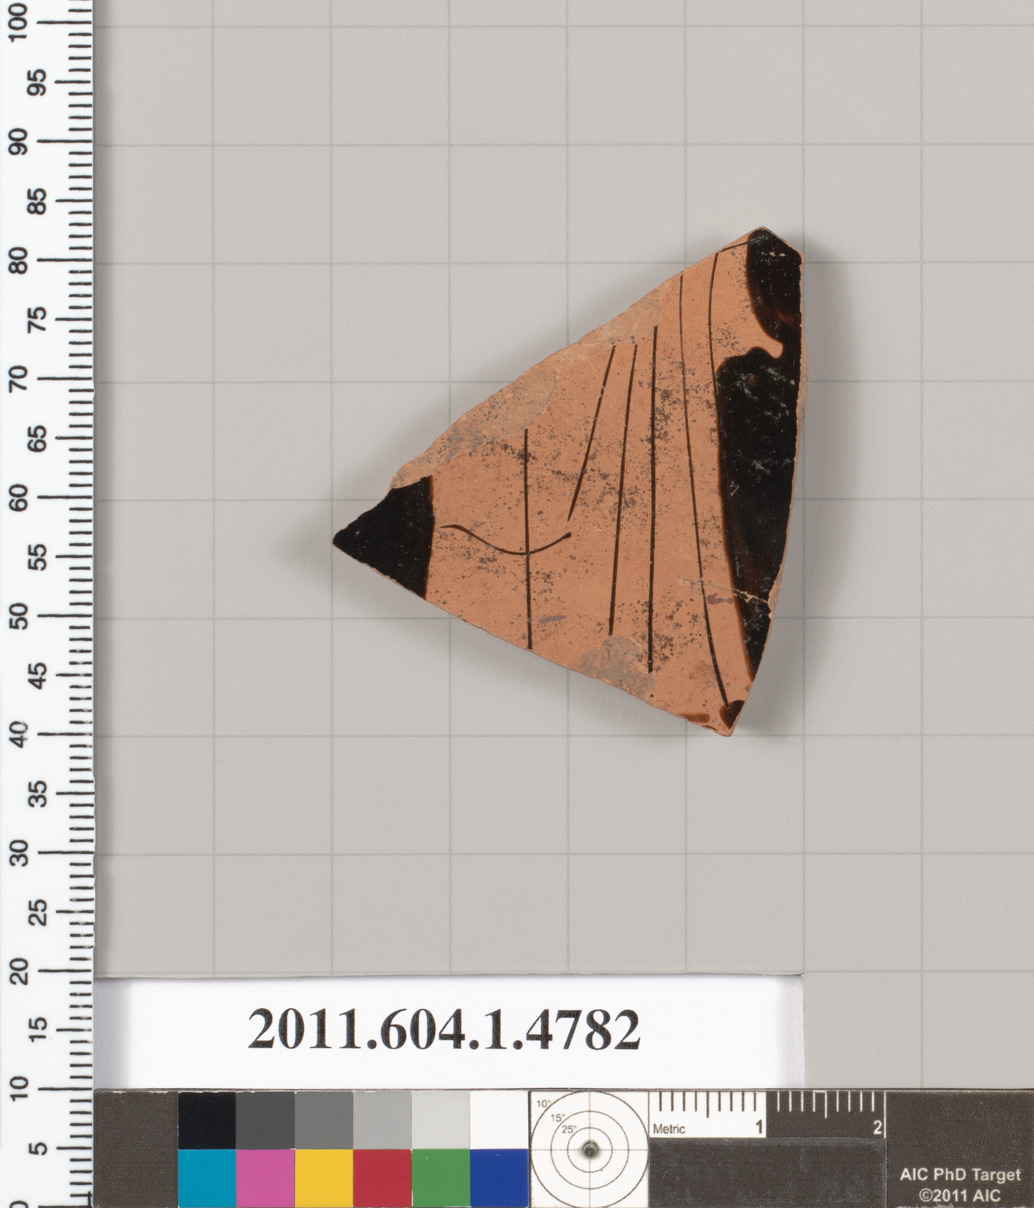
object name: kylix fragment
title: Terracotta fragment of a kylix (drinking cup)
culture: greek, attic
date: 475-451 BCE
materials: terracotta